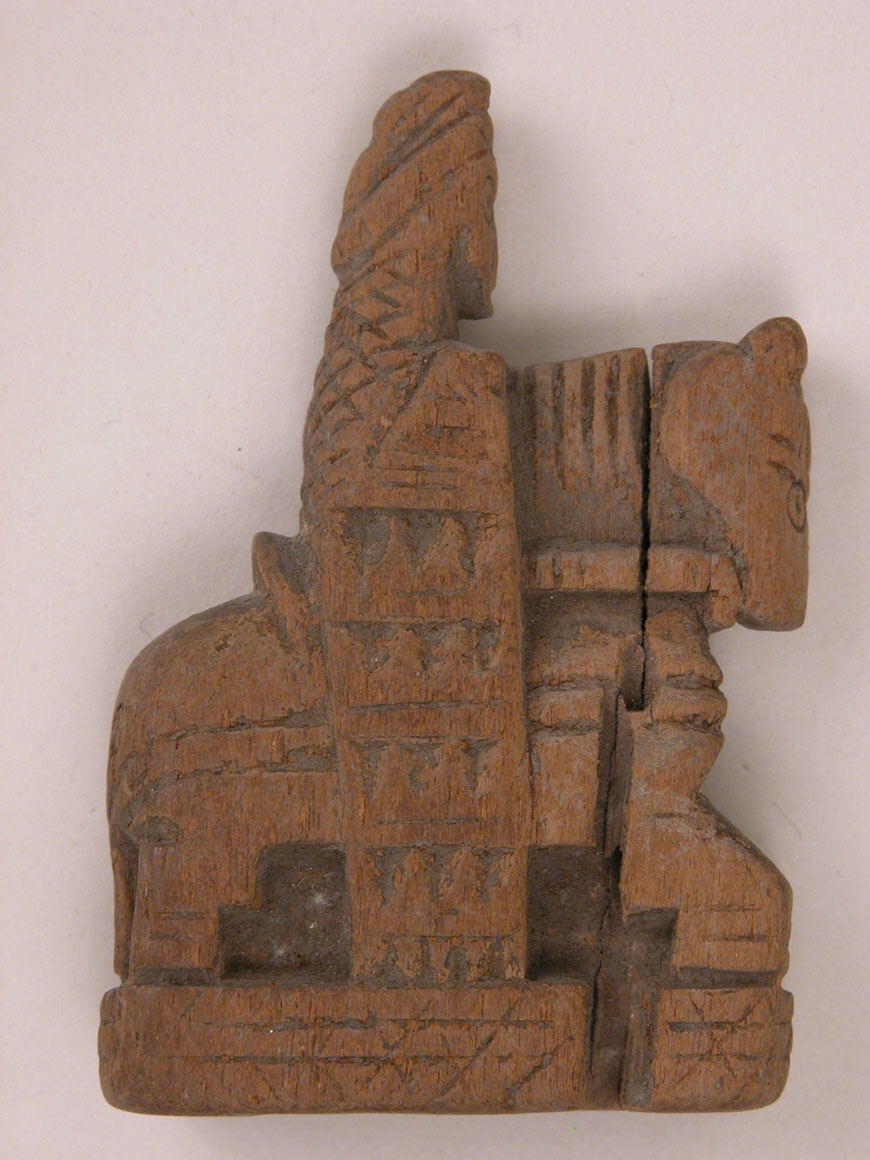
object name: chess piece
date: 601-800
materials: wood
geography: egypt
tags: chess,games